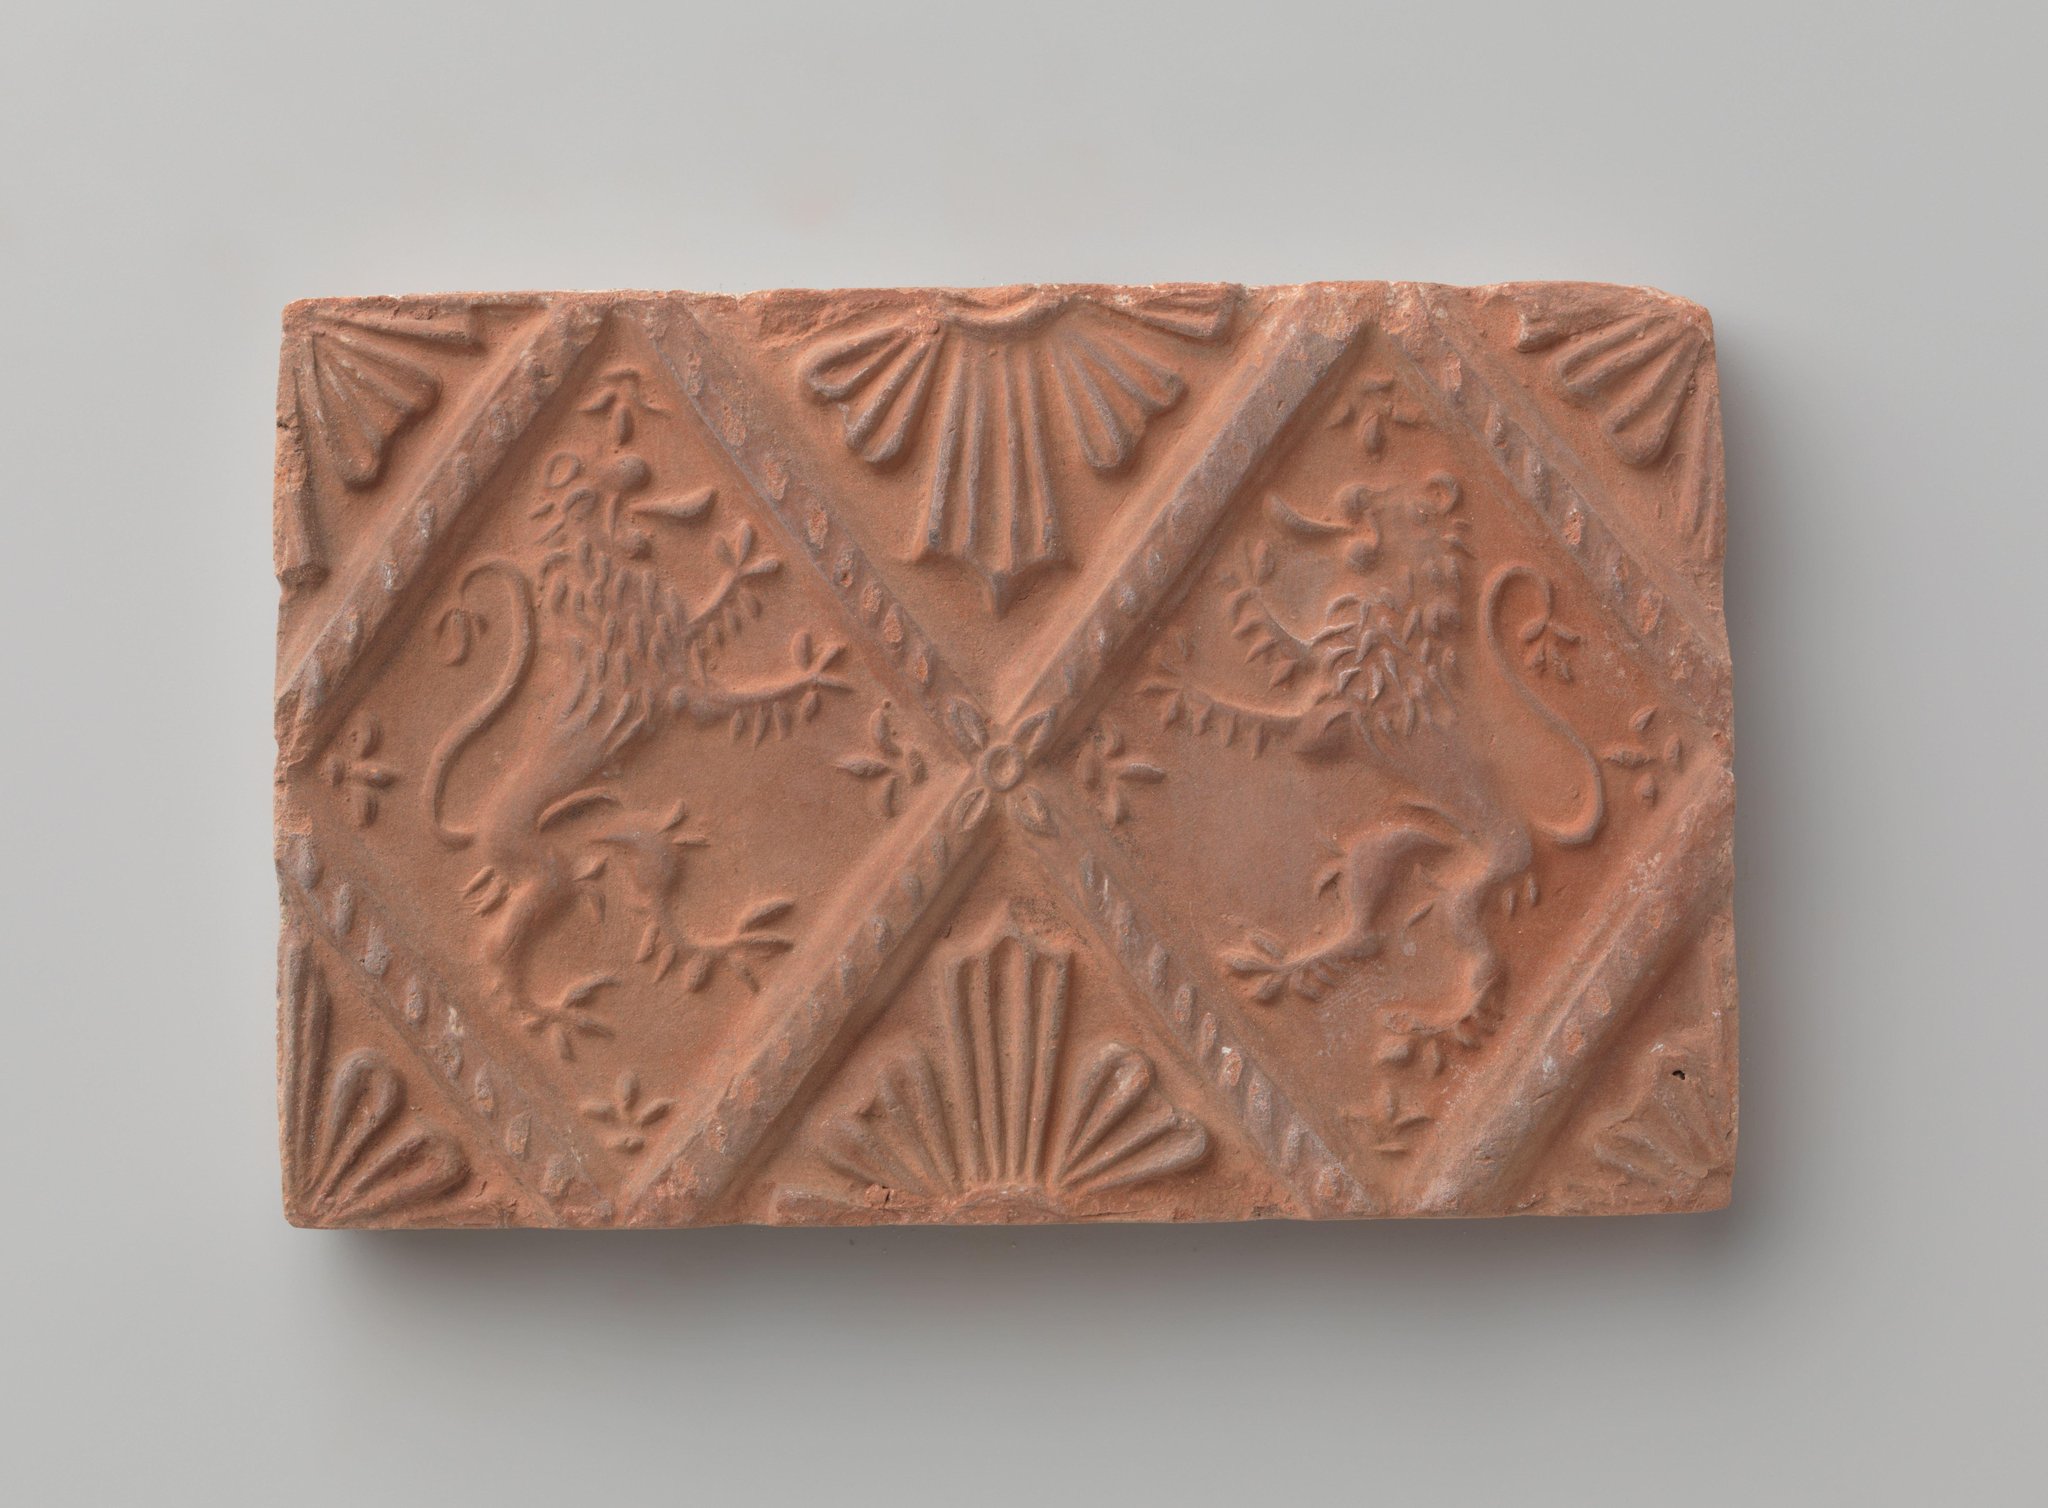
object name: hearthstone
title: Haardsteen met voorstelling van twee klimmende leeuwen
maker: Anonymous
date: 1875-1900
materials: earthenware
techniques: printing, firing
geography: netherlands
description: Haardsteen met voorstelling van twee klimmende leeuwen, geplaatst in geprofileerde ruit. De halve ruiten aan de boven- en onderkant zijn opgevuld met stermotief.